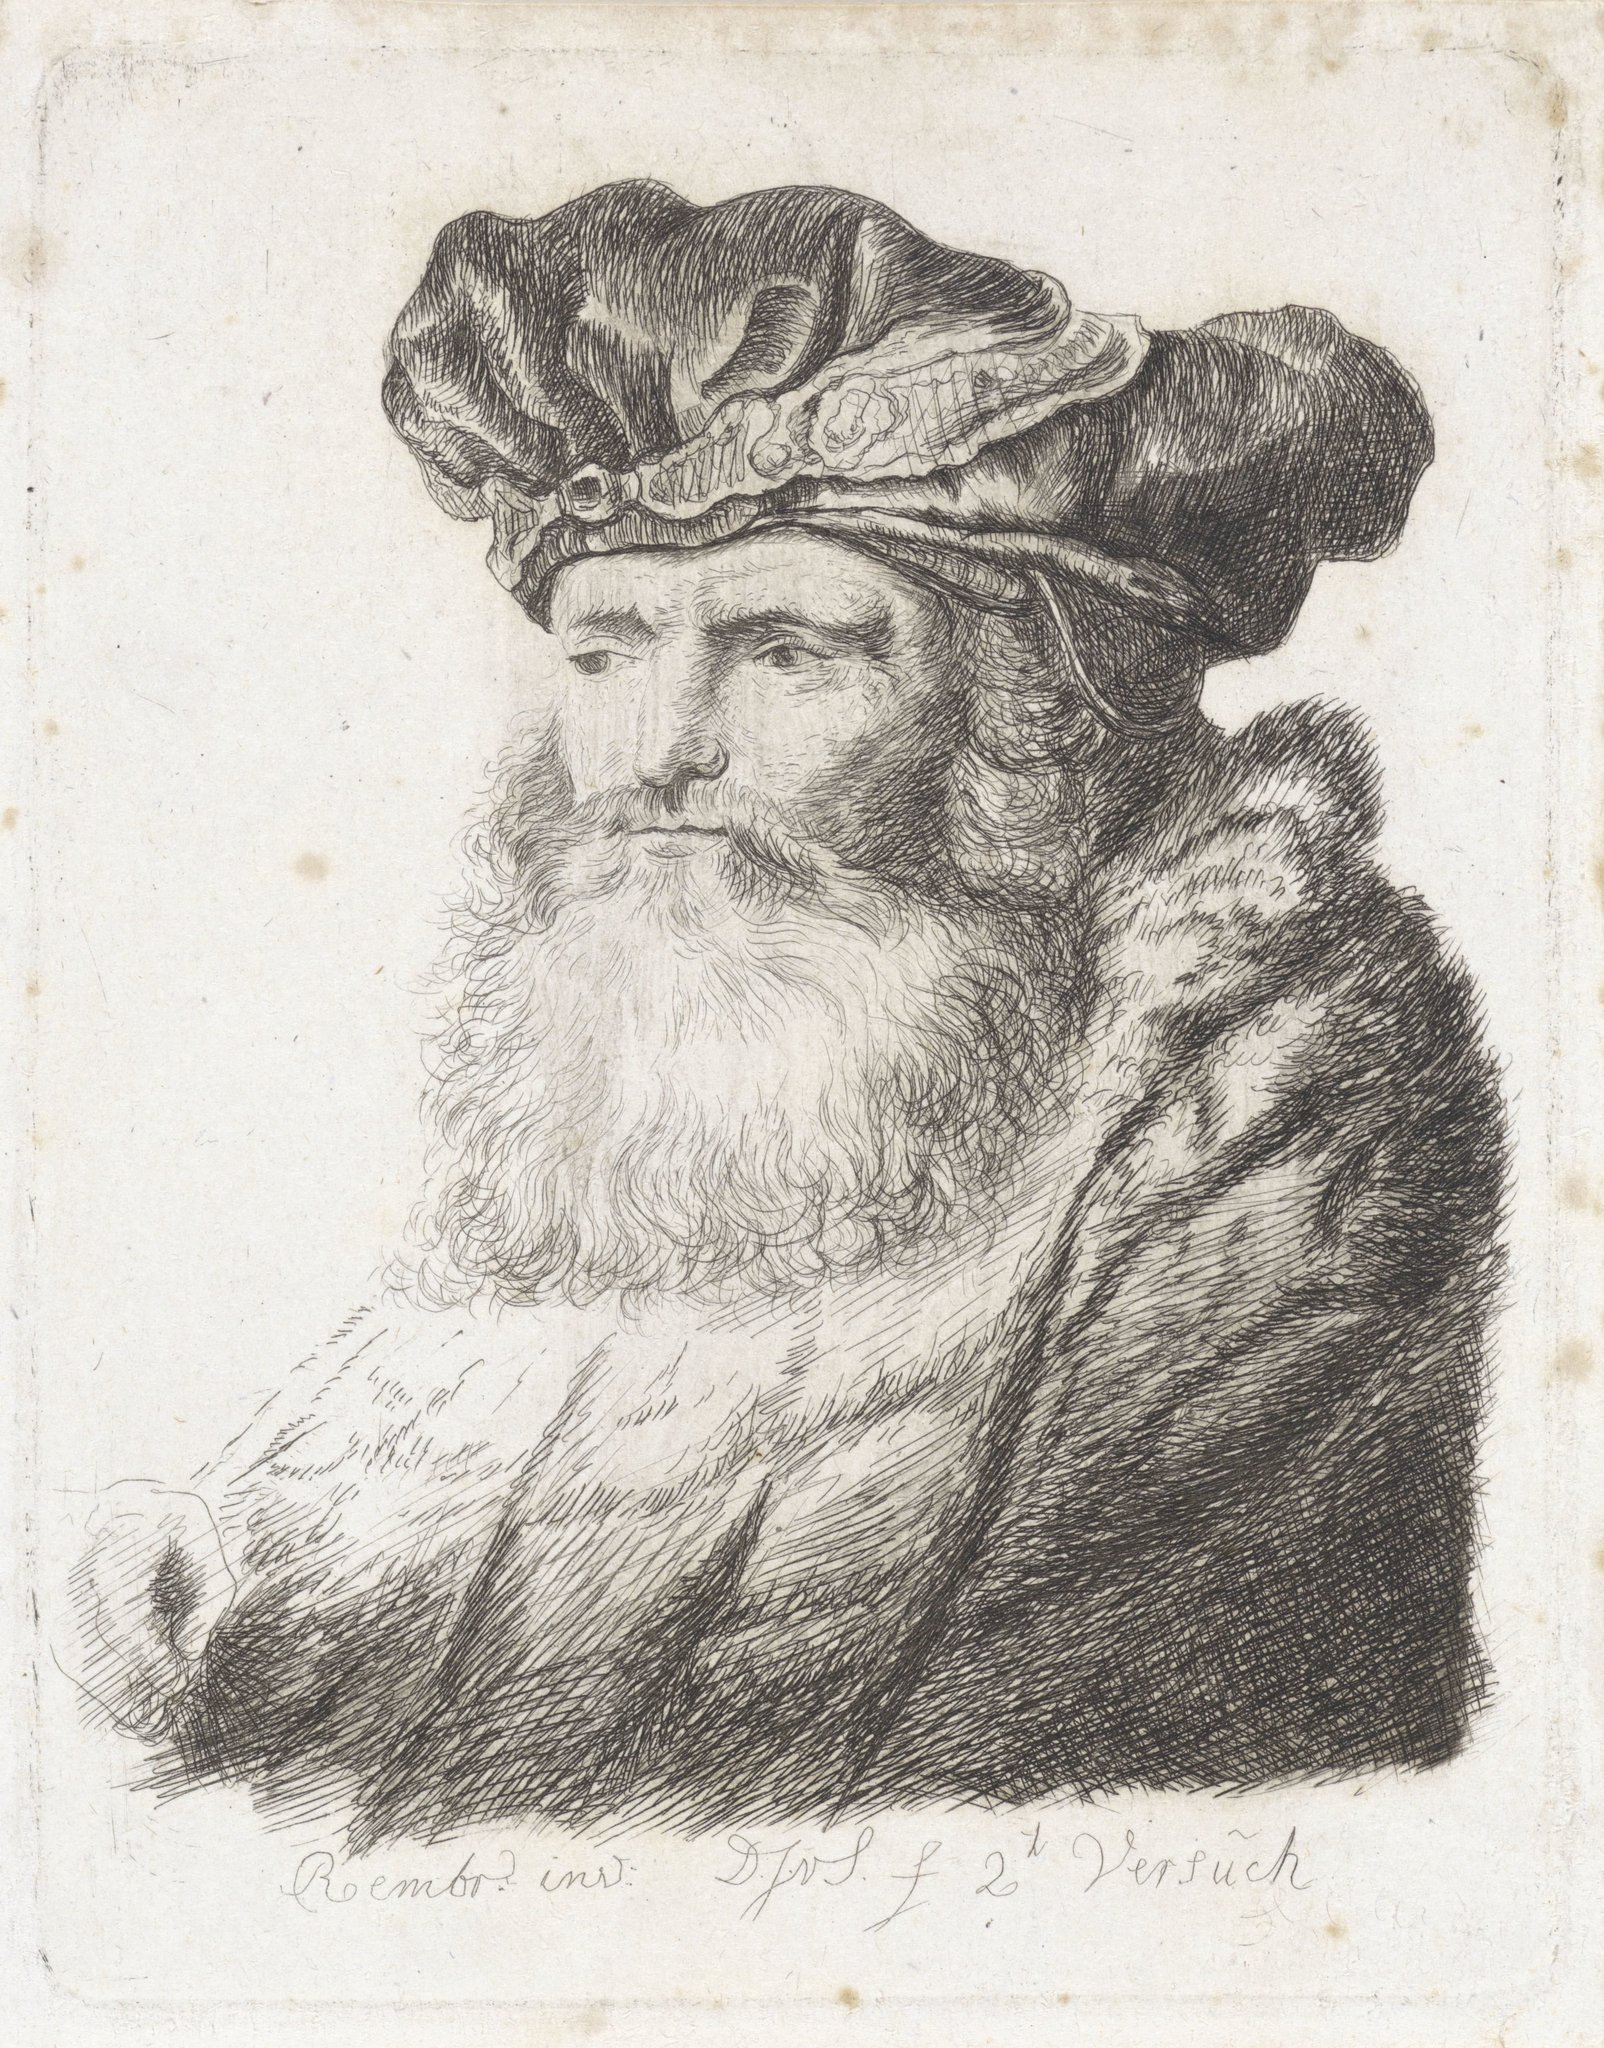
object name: print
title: Man met baard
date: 1801-1833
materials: paper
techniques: etching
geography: utrecht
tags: historical persons not known by name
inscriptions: collector's mark: Lugt 2228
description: Man met baard en met juwelen en band versierde baret. Hij draagt een bontmantel. In de marge beneden "2e Versuch".